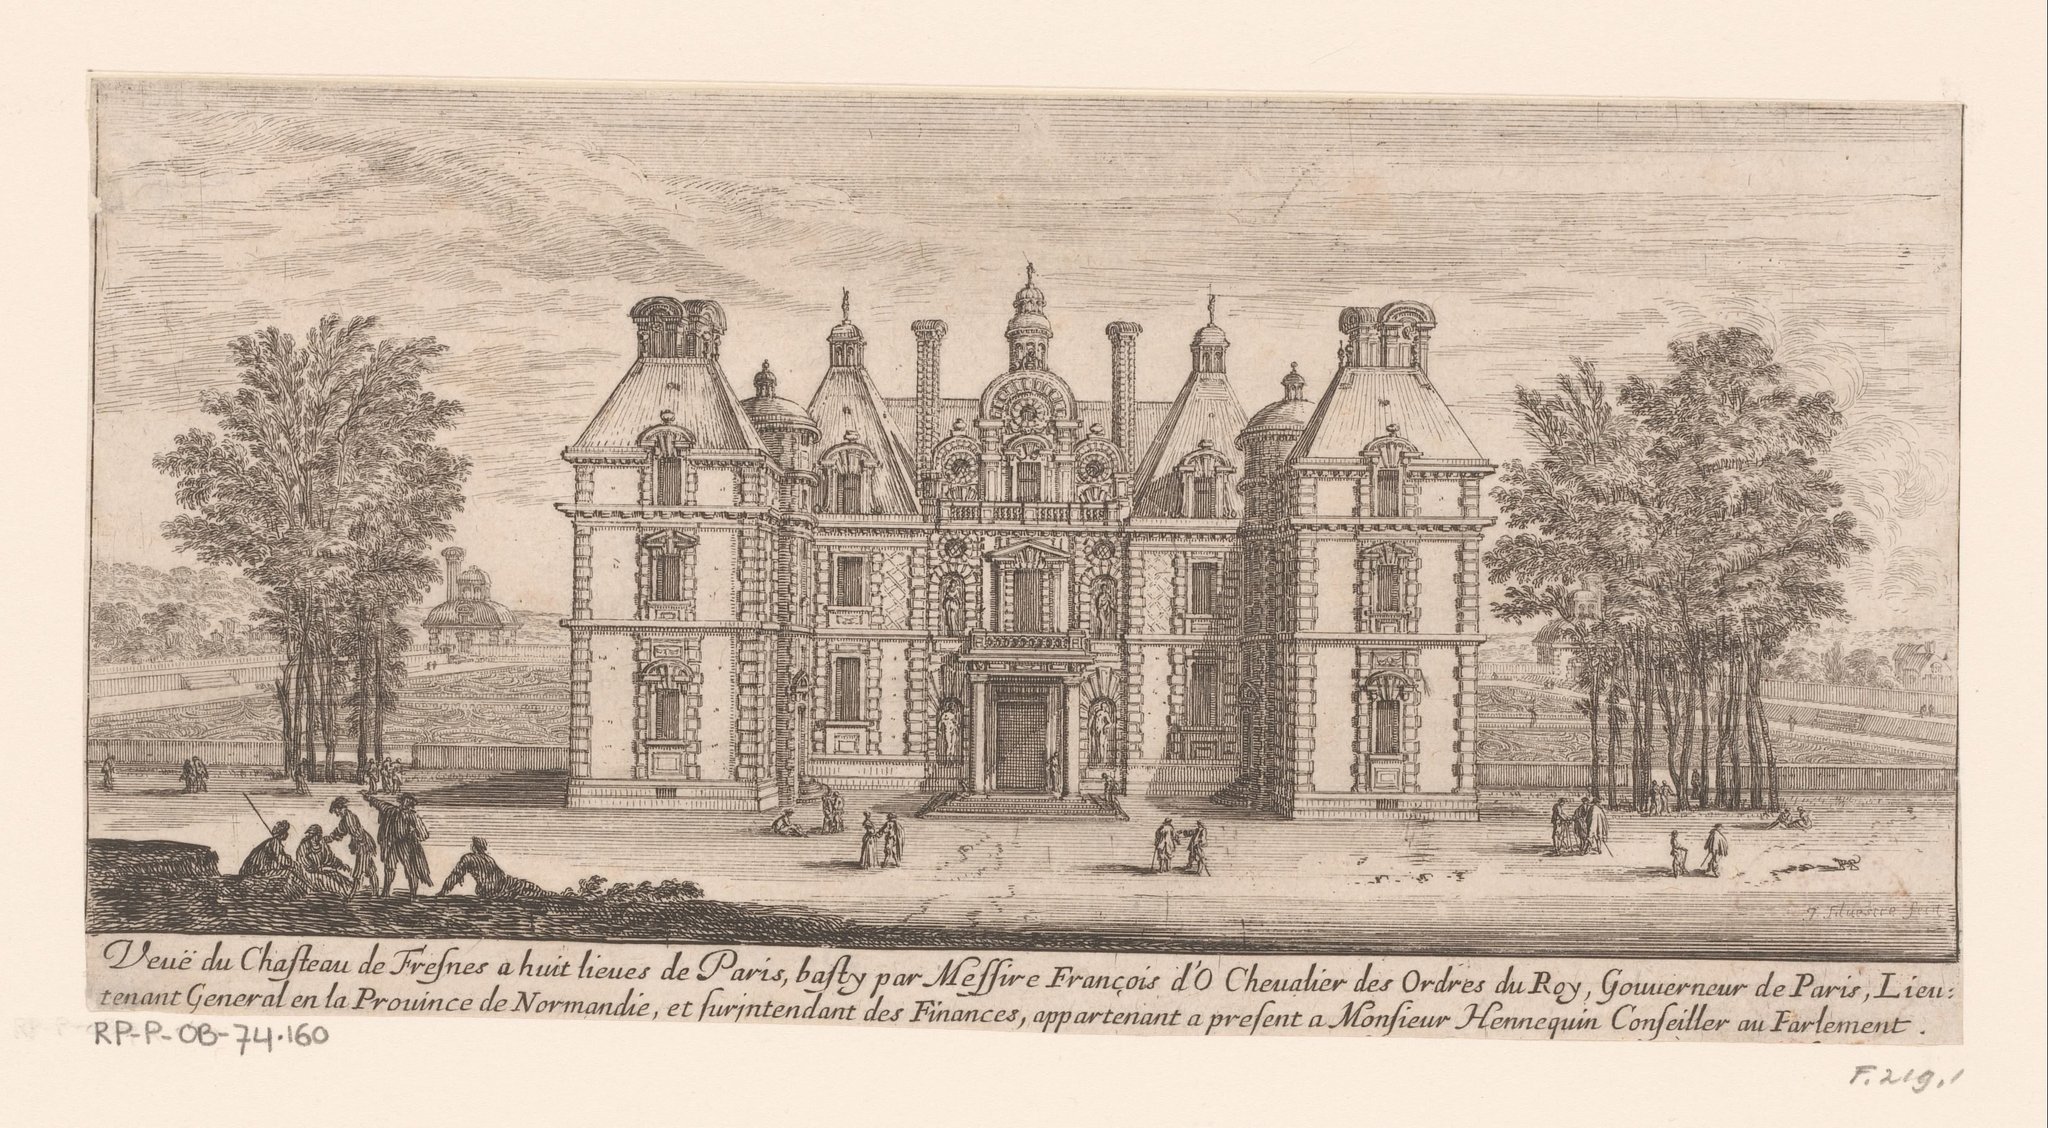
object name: print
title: Gezicht op het kasteel van Fresne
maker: israël silvestre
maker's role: draughtsman, print maker, publisher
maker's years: 1621-1691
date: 1631-1691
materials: paper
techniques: engraving, etching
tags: french or architectonic garden; formal garden, landscape with tower or castle (+ city(-scape) with figures, staffage)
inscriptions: collector's mark: Lugt 240